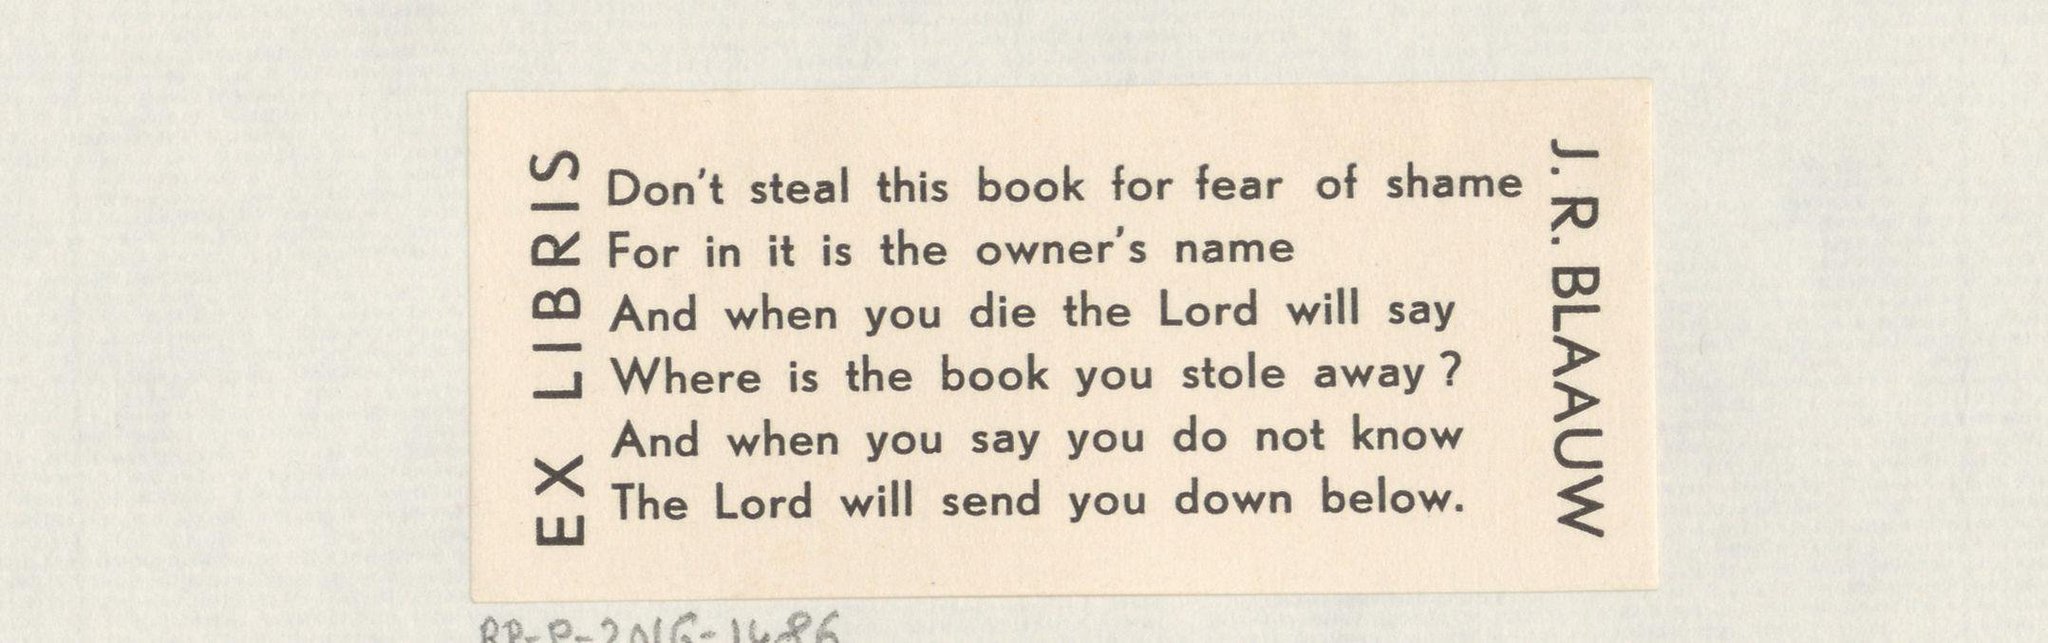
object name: bookplate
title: Ex libris van J.R. Blaauw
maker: Anonymous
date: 1920-1961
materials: paper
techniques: letterpress printing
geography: netherlands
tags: engineer